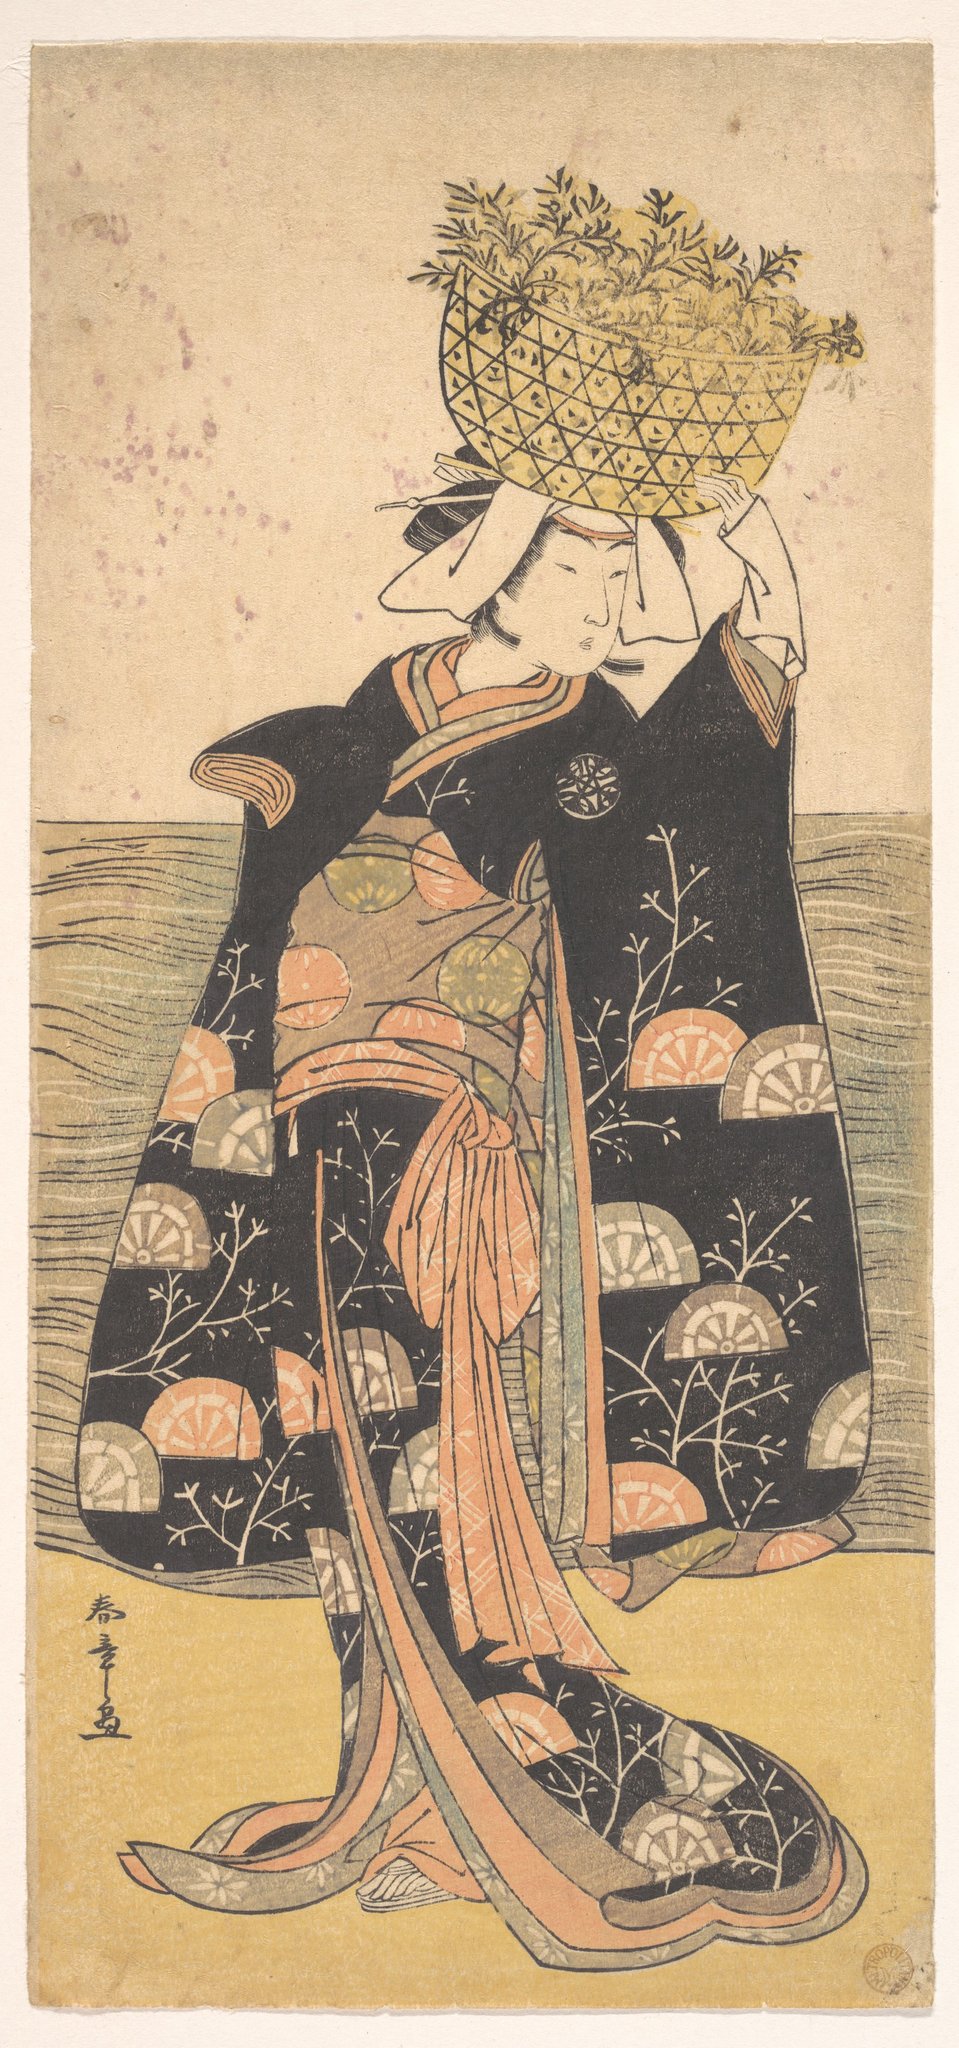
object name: woodblock print nishiki e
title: The First Nakamura Nakazo in the Role of the Ghost of Shiragiku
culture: japanese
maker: katsukawa shunshō 勝川春章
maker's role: artist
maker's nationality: japanese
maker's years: 1726-1792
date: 1778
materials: ink, paper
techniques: nishiki e, woodblock print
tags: women,actors